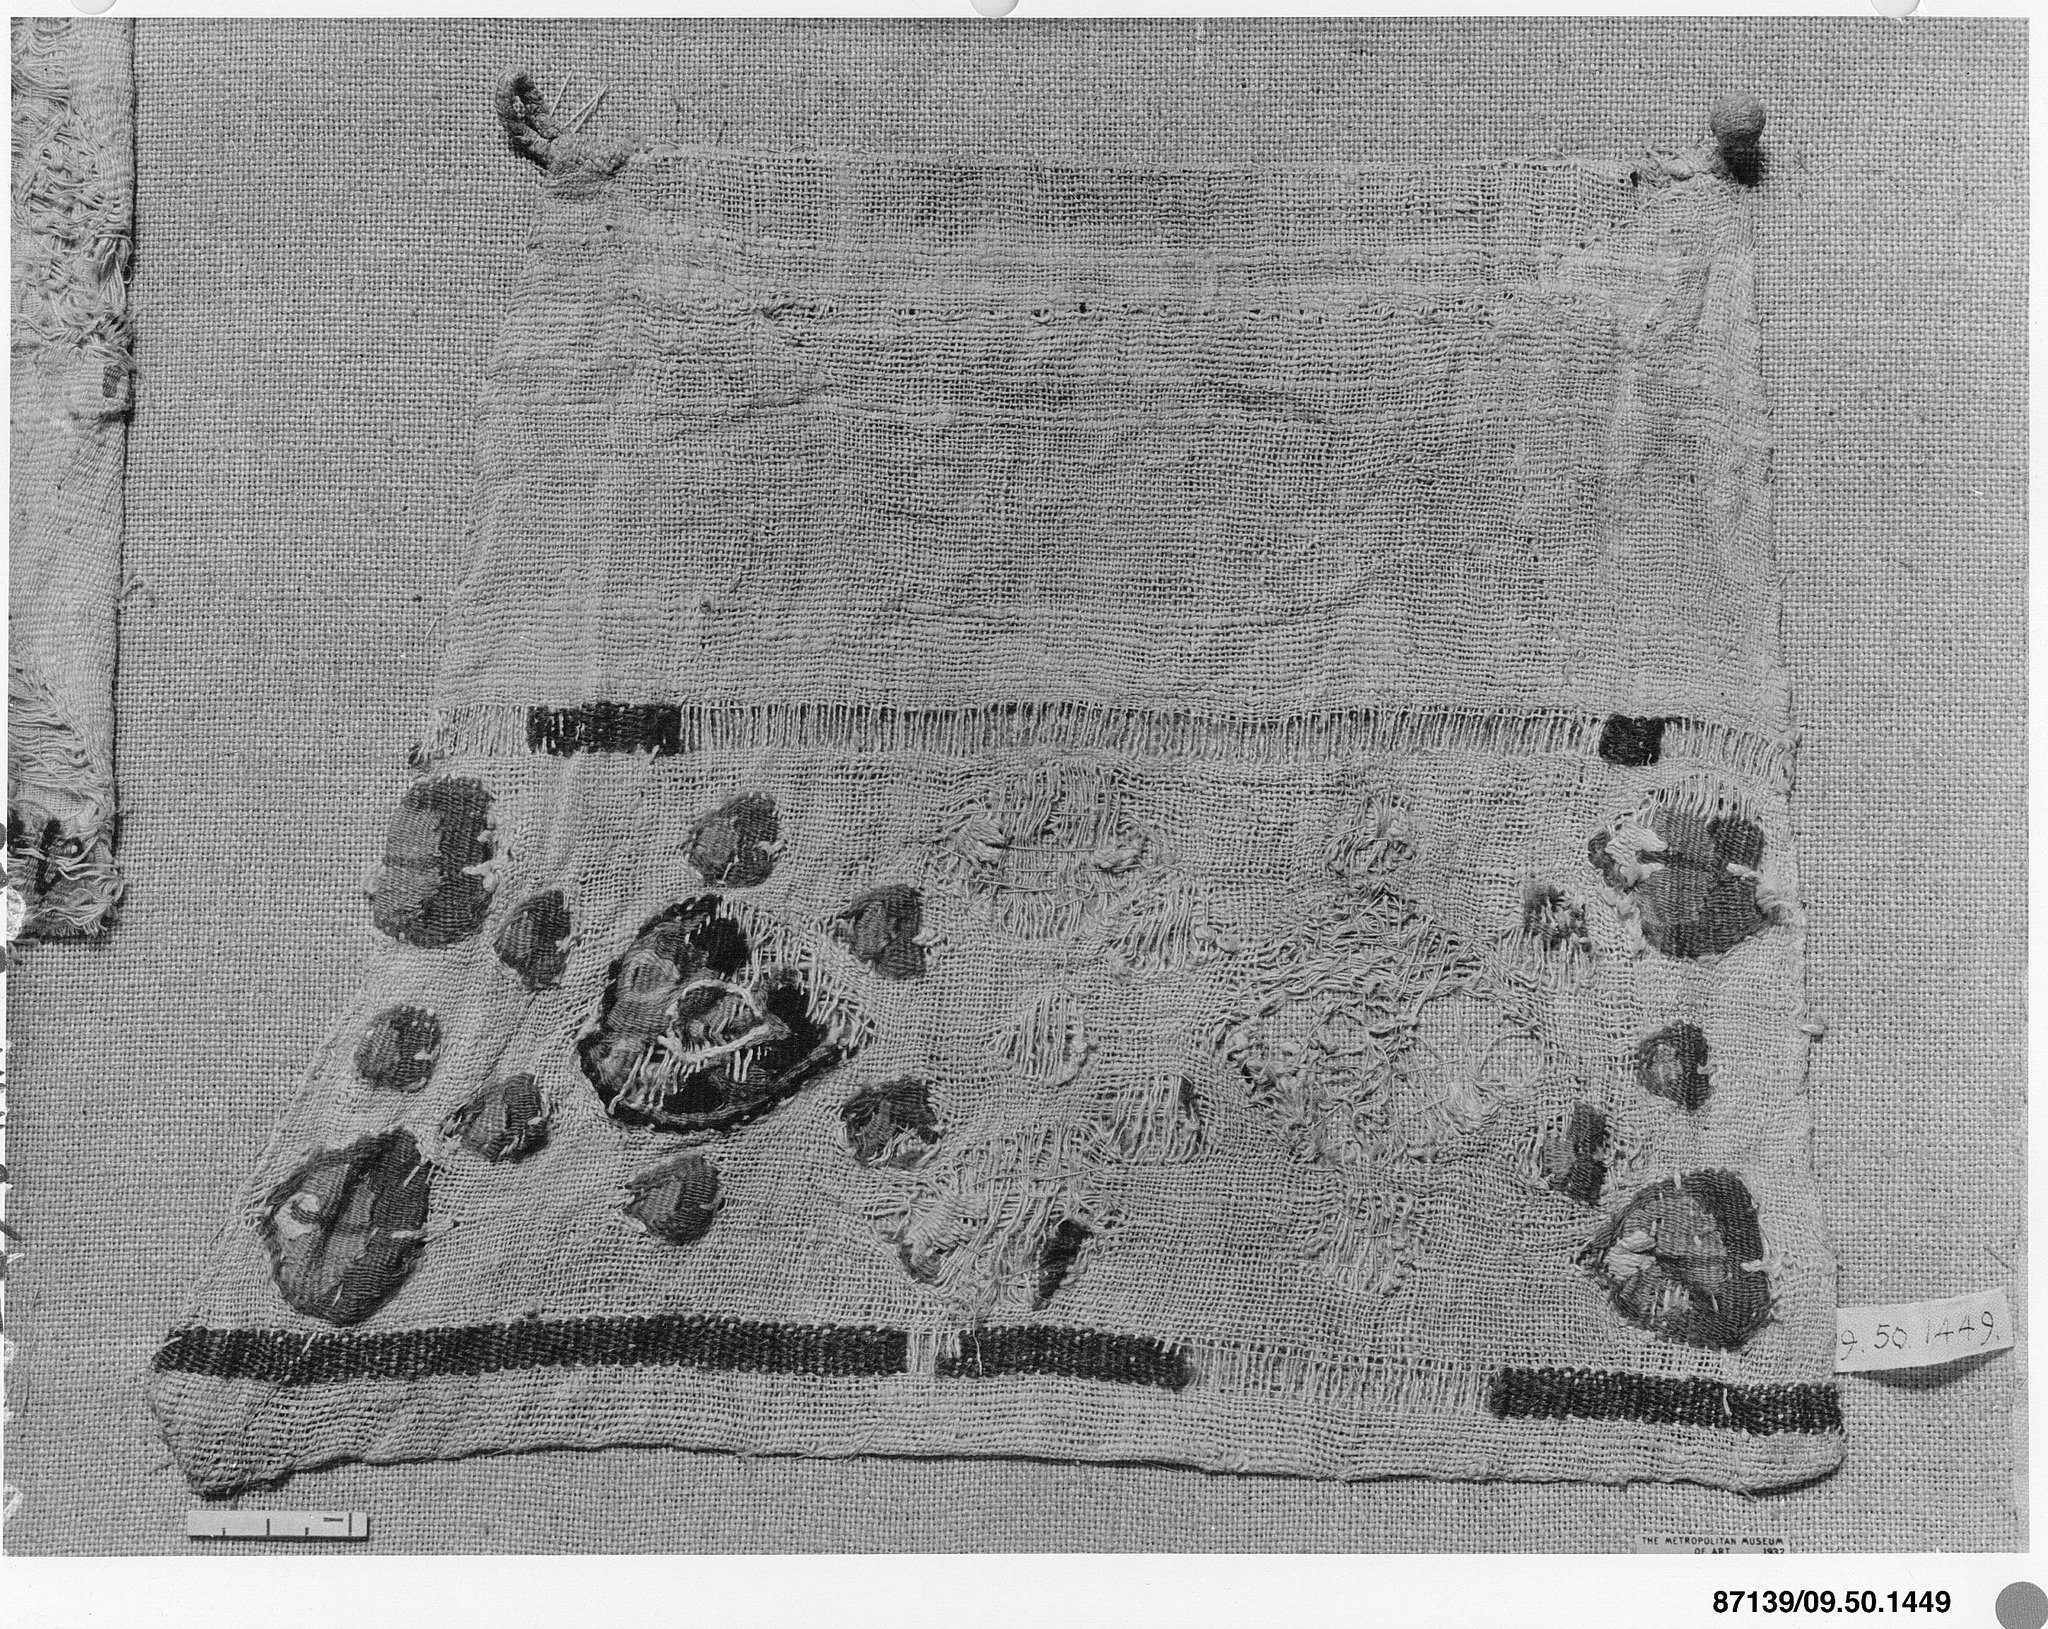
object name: textile fragment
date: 401-600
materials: linen, wool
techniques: weave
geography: egypt